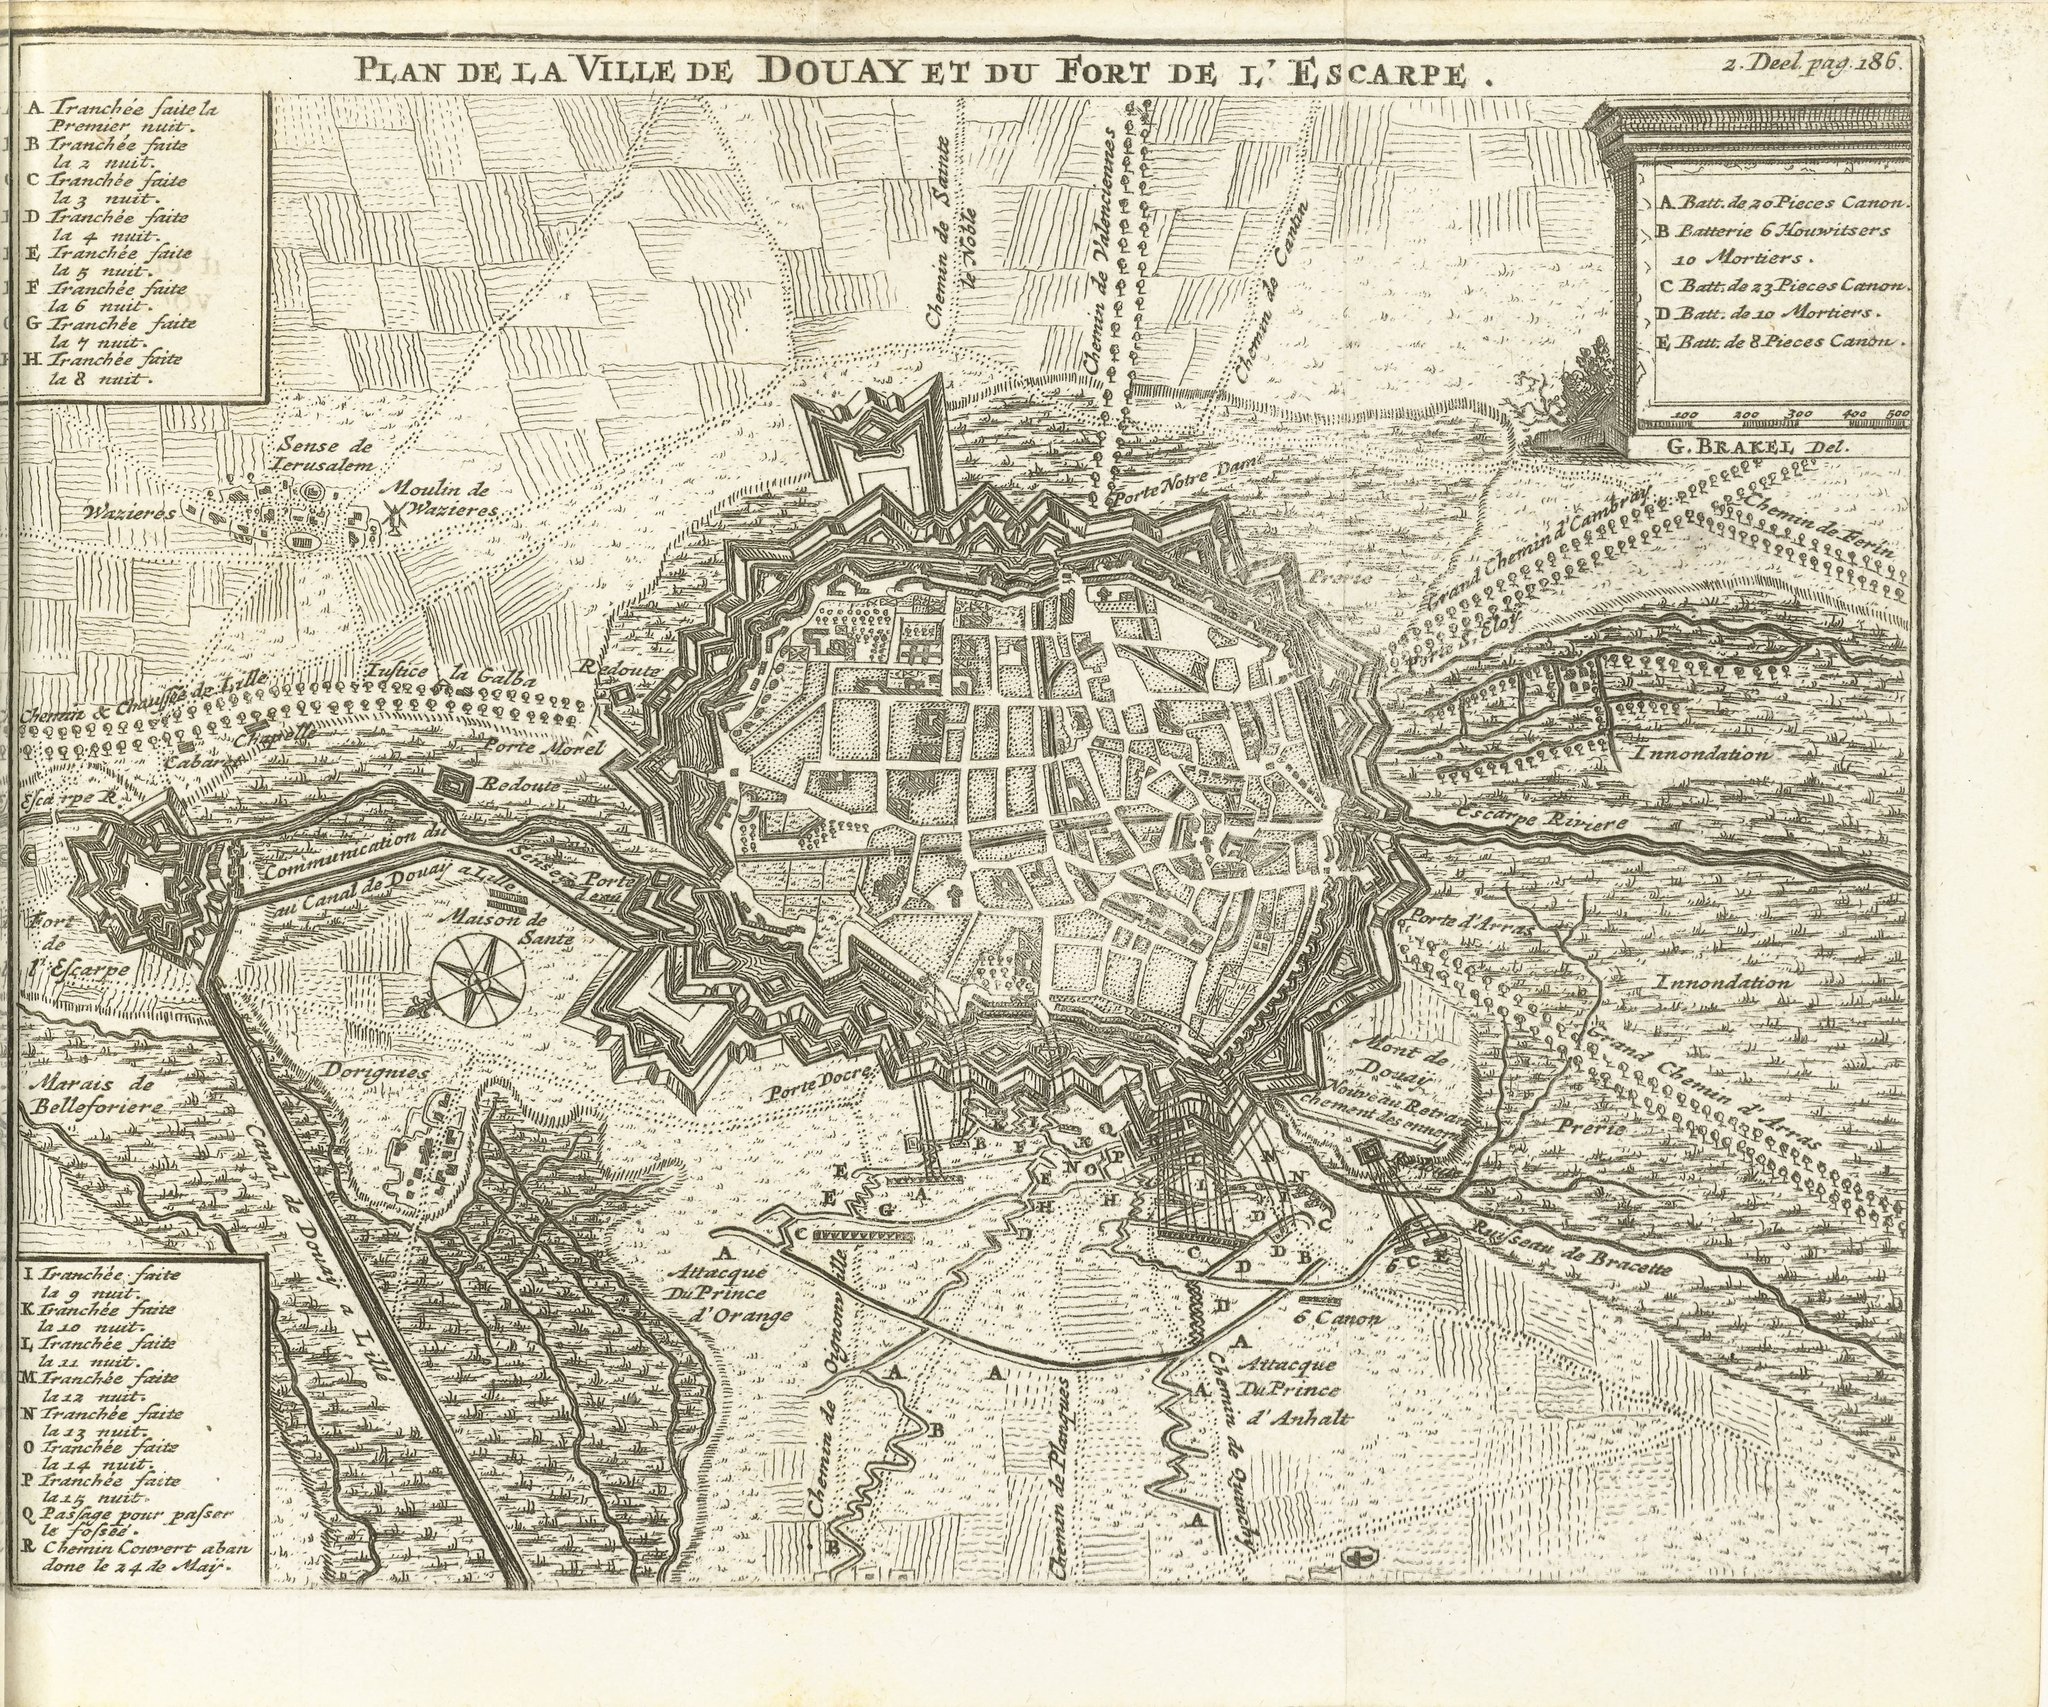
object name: print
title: Beleg van Douai, 1710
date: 1714-1716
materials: paper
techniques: etching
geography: amsterdam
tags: johan willem friso (prins van oranje-nassau), siege, position war, maps of cities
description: Kaart van Douai, belegerd en door de geallieerden en ingenomen op 29 juni 1710. Illustratie in de Nederlandse vertaling uit 1716 van J. Lamigue, Het leven van Zyne Hoogheit Johan Willem Friso, dl. II, p. 186/187.